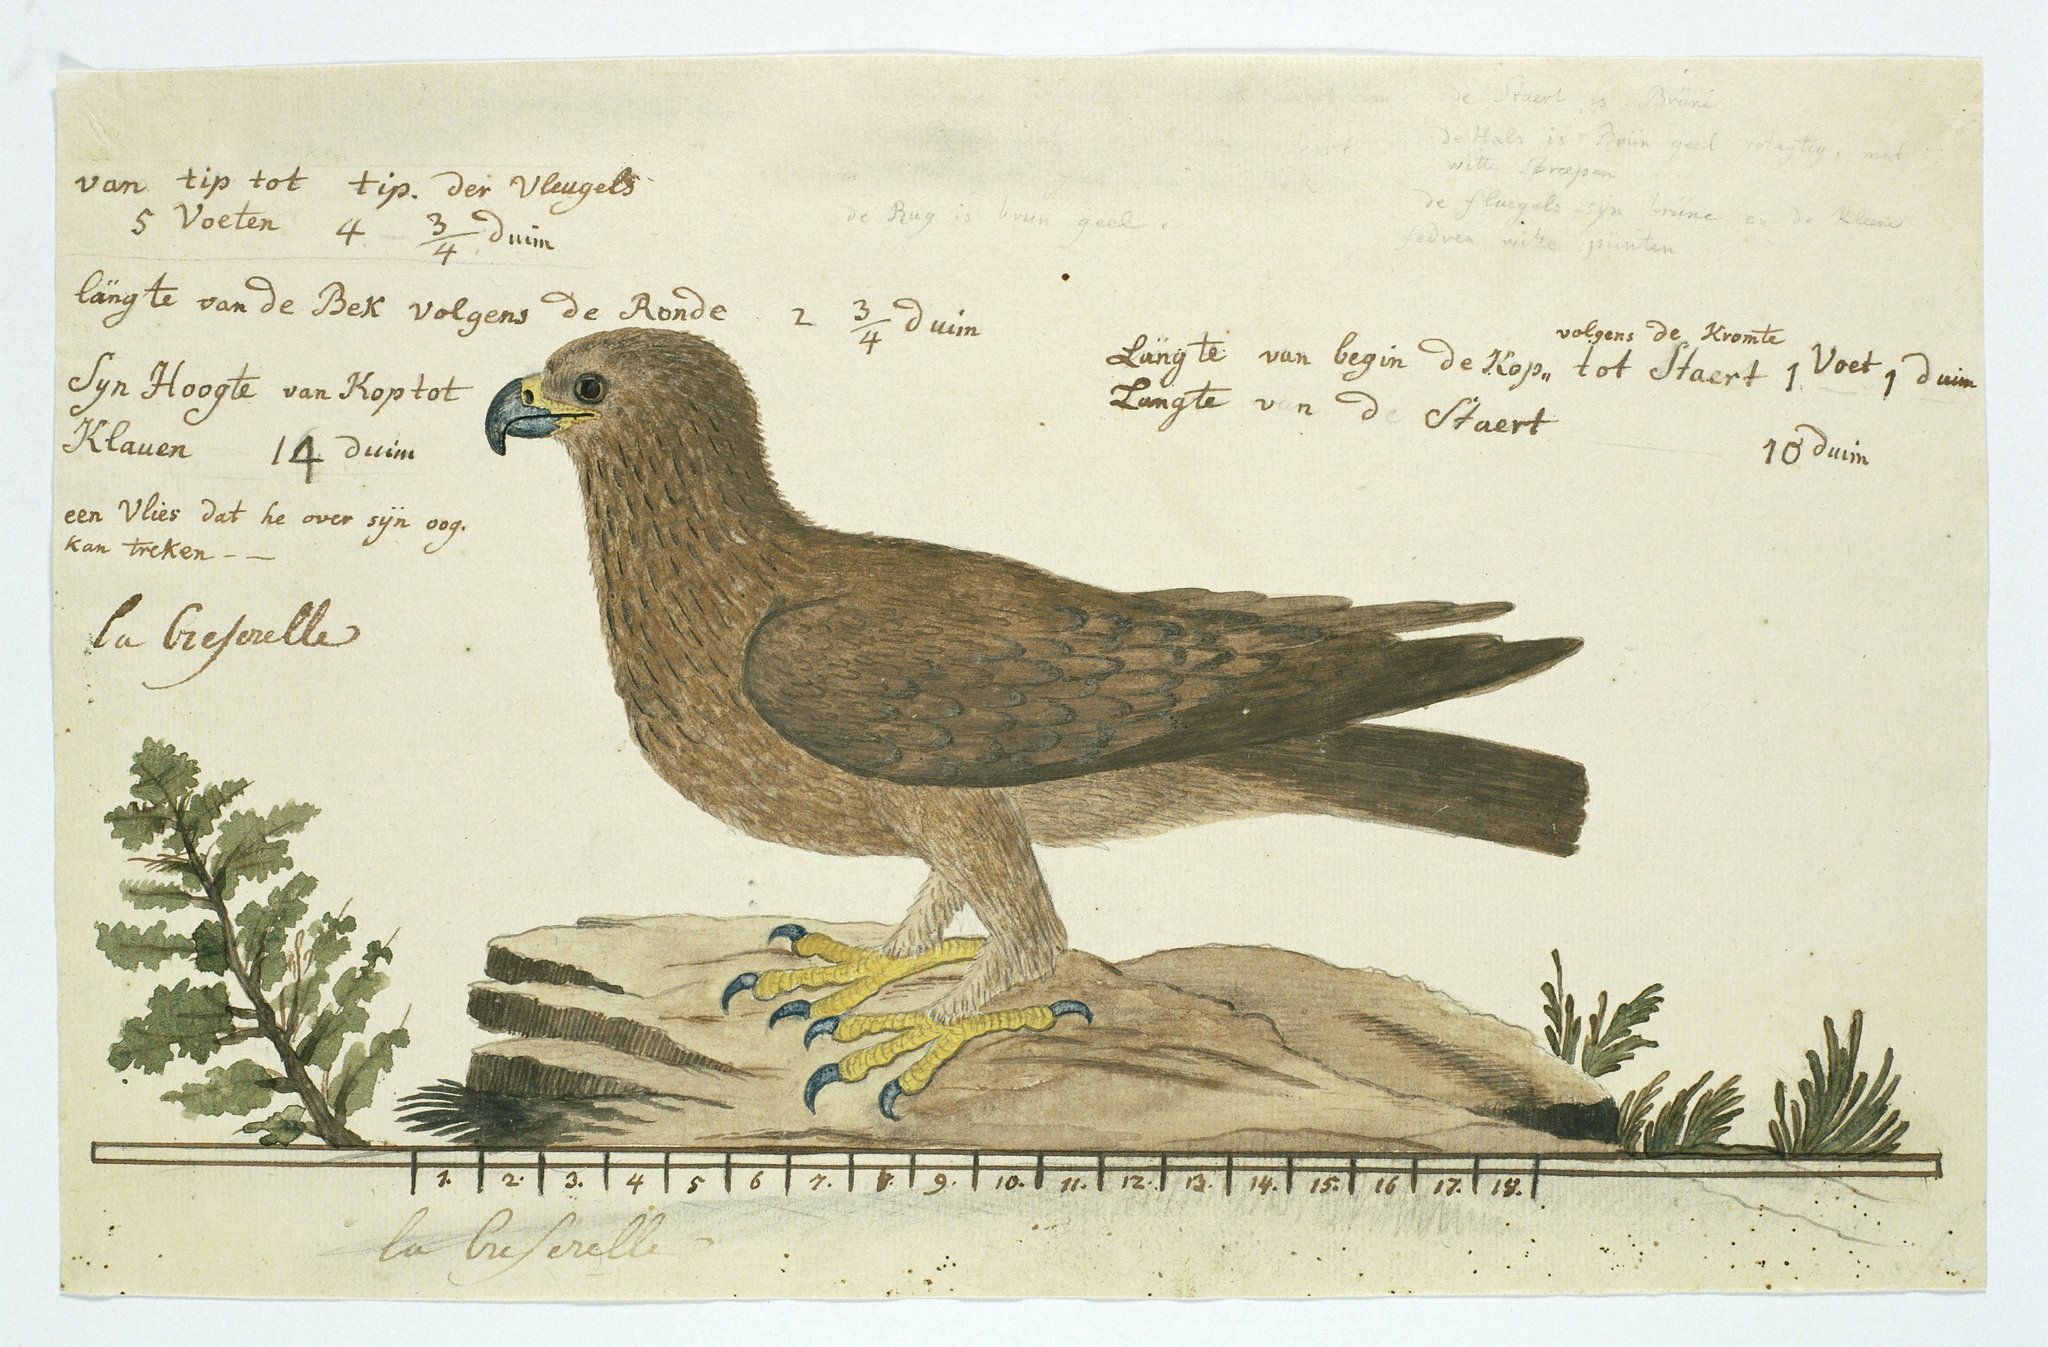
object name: drawing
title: Hieraaetus pennatus (Booted eagle)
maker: robert jacob gordon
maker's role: draughtsman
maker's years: 1743-1795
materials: chalk, ink, paper, pencil, watercolor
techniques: brush, pen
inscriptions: annotation: ‘[...] zie Rookmaker; La Creserelle / Lengte [....]’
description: Vogelstudie: Dwergarend, of roodbruine arend (Hieraaetus pennatus?); met schaalindeling in Rijnlandse voet en duim.